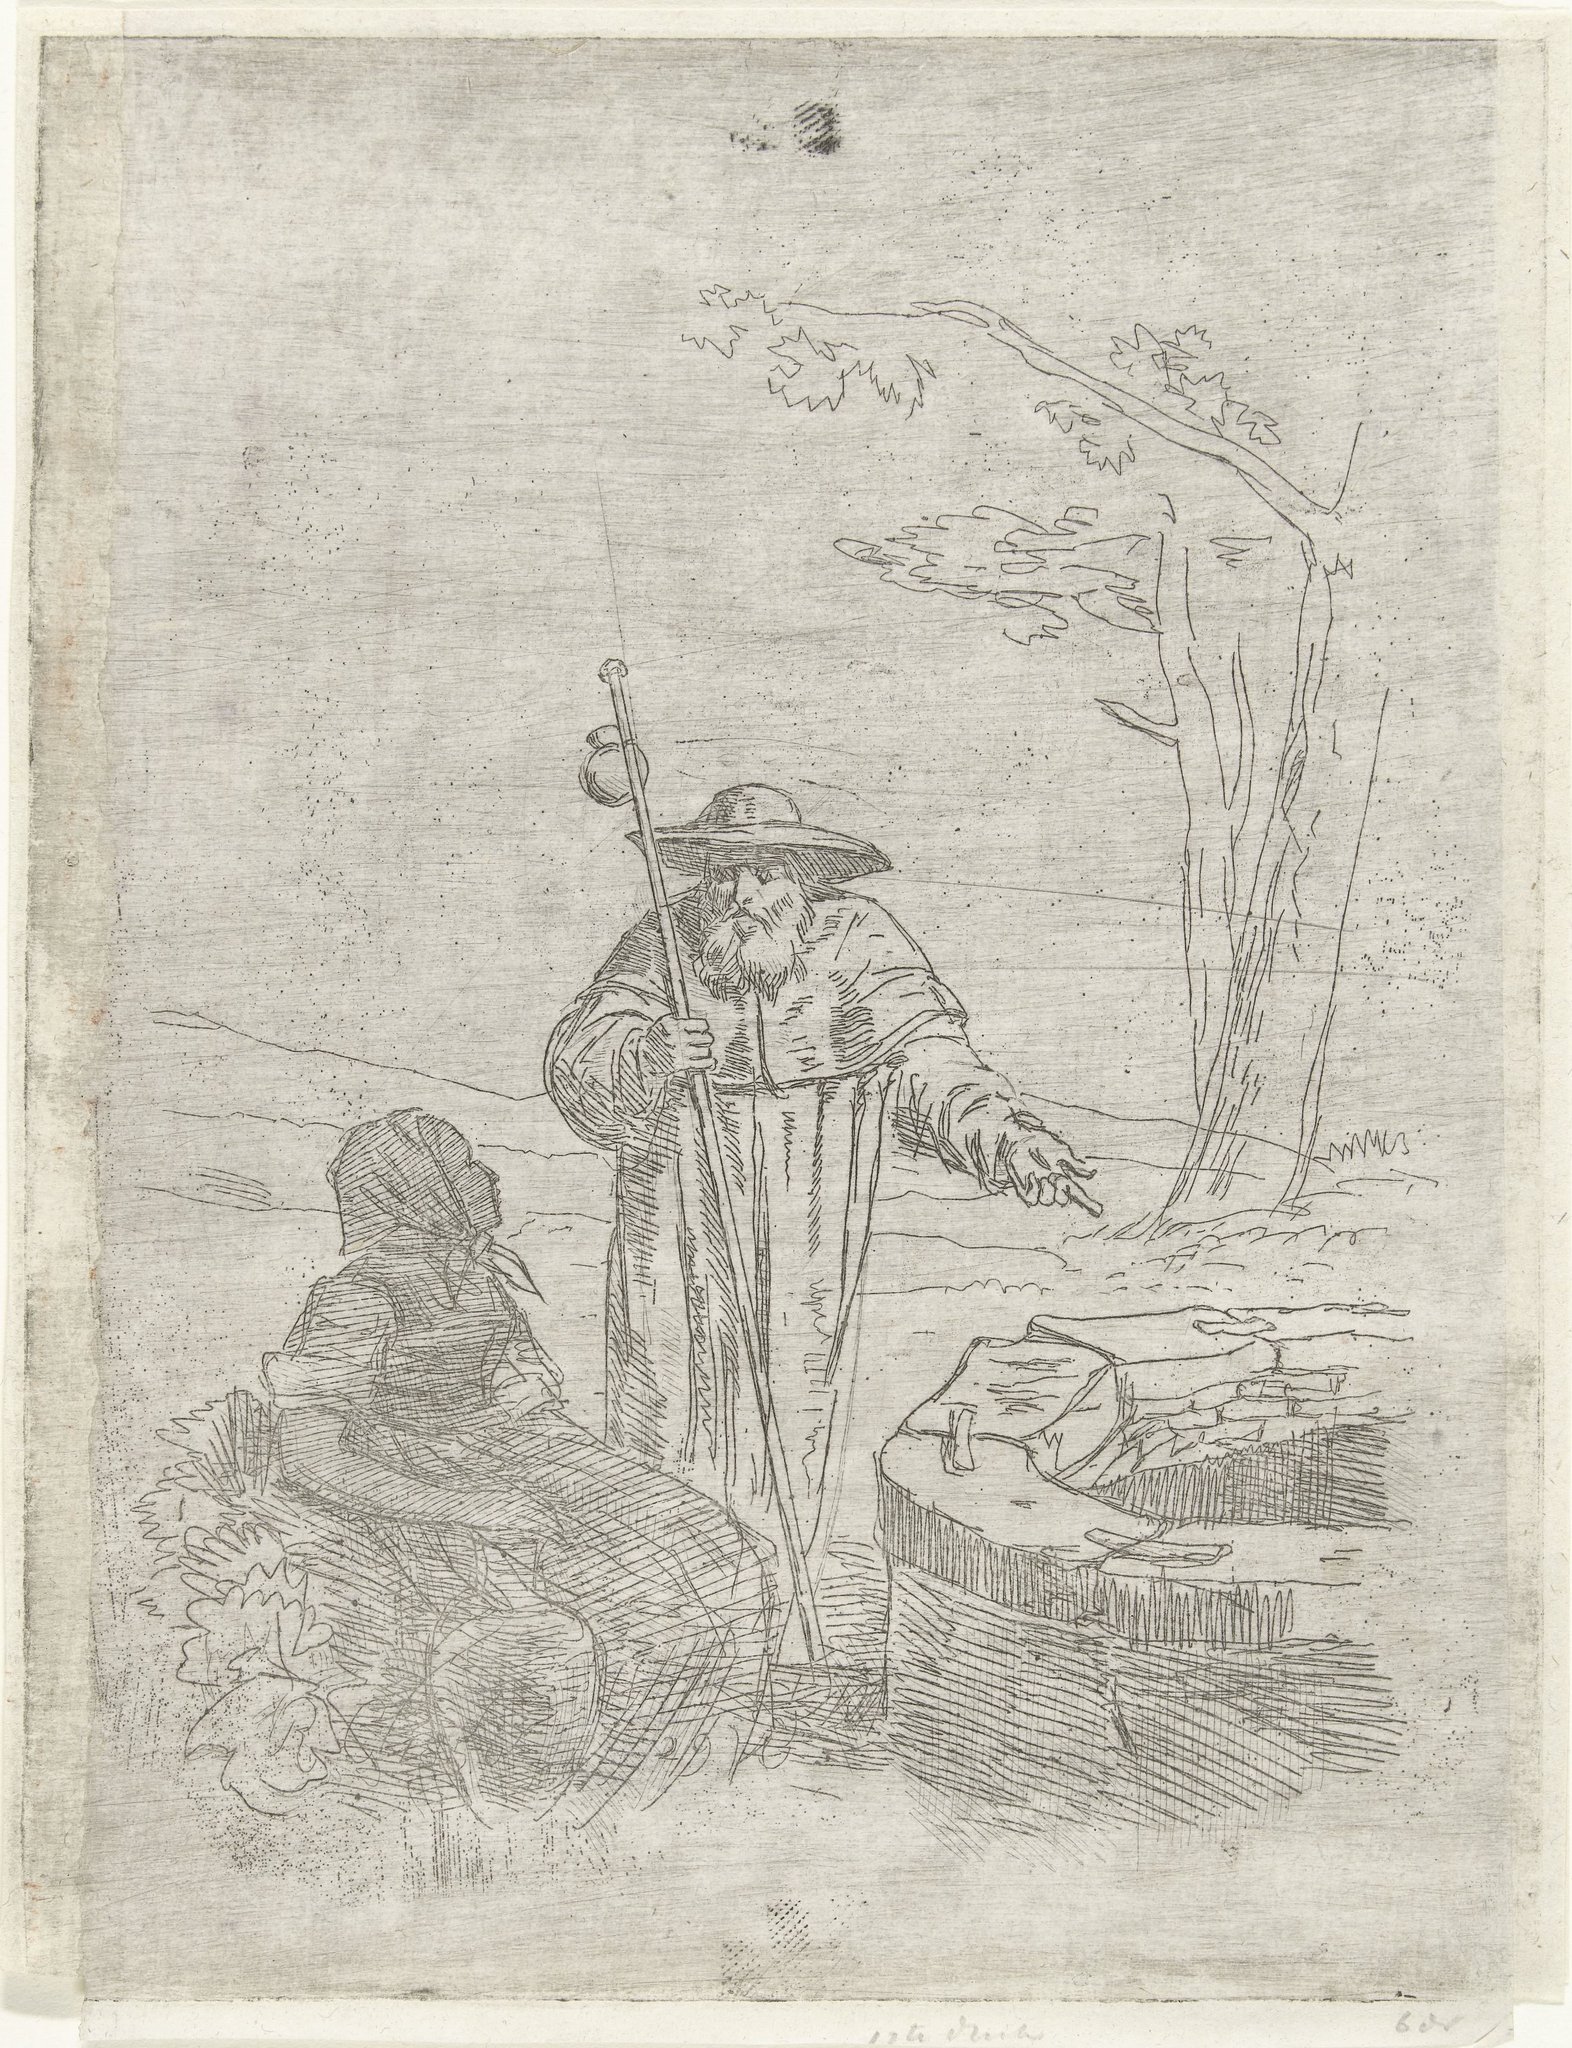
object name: print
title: Pelgim in gesprek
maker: reinier craeyvanger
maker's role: draughtsman, print maker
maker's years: 1812-1880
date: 1822-1880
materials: paper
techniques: etching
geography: amsterdam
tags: well, pilgrim(s), farmers - aa - female farmer, farmer's wife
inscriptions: collector's mark: Lugt 2228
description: Een boerin bij een put in gesprek met een pelgrim.